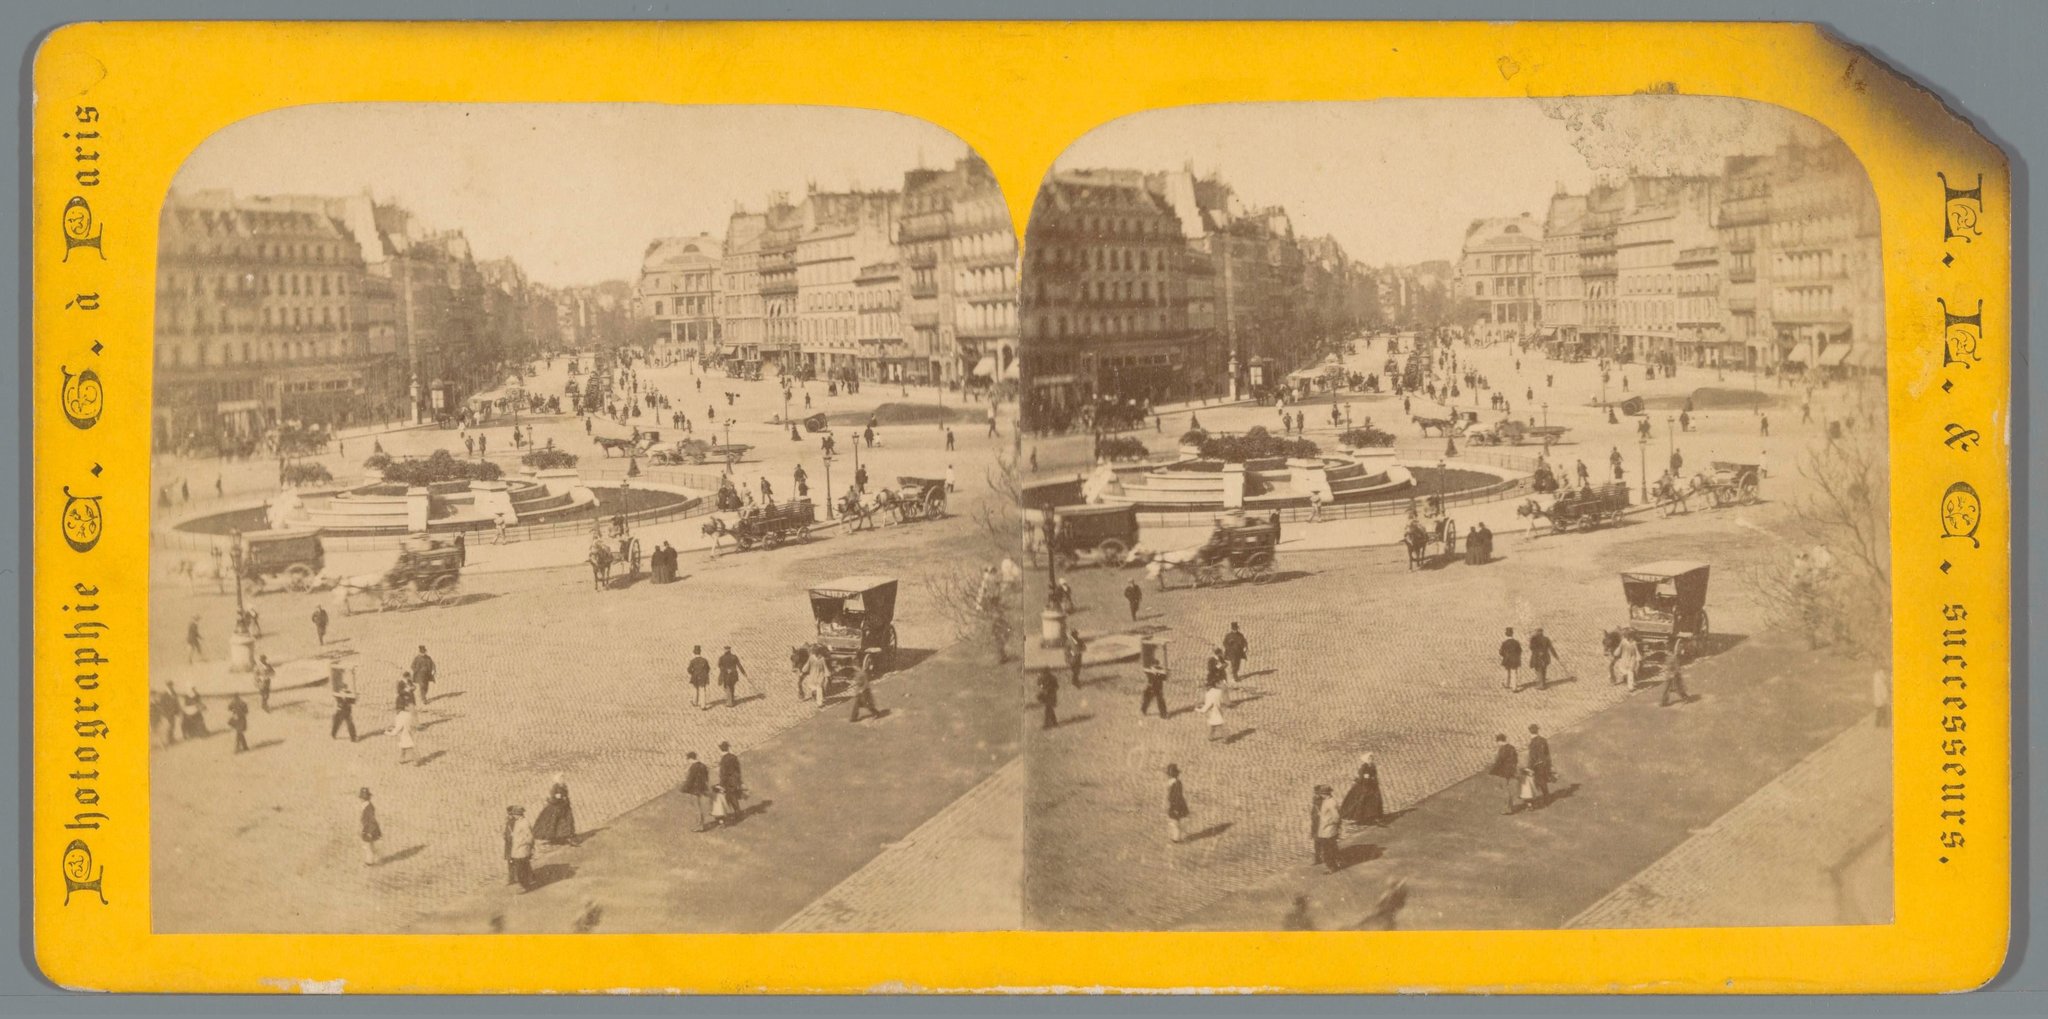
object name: stereograph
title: Gezicht op het Place du Château d'Eau in Parijs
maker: charles gérard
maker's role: fotograaf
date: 1860-1870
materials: cardboard, photographic support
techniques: albumen print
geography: paris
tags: square, place, circus, etc., animal traction, animal-drawn vehicle (carriage etc.)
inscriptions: name: ‘L.L & C. successeurs’, inscription: ‘Place du chateau d'eau’